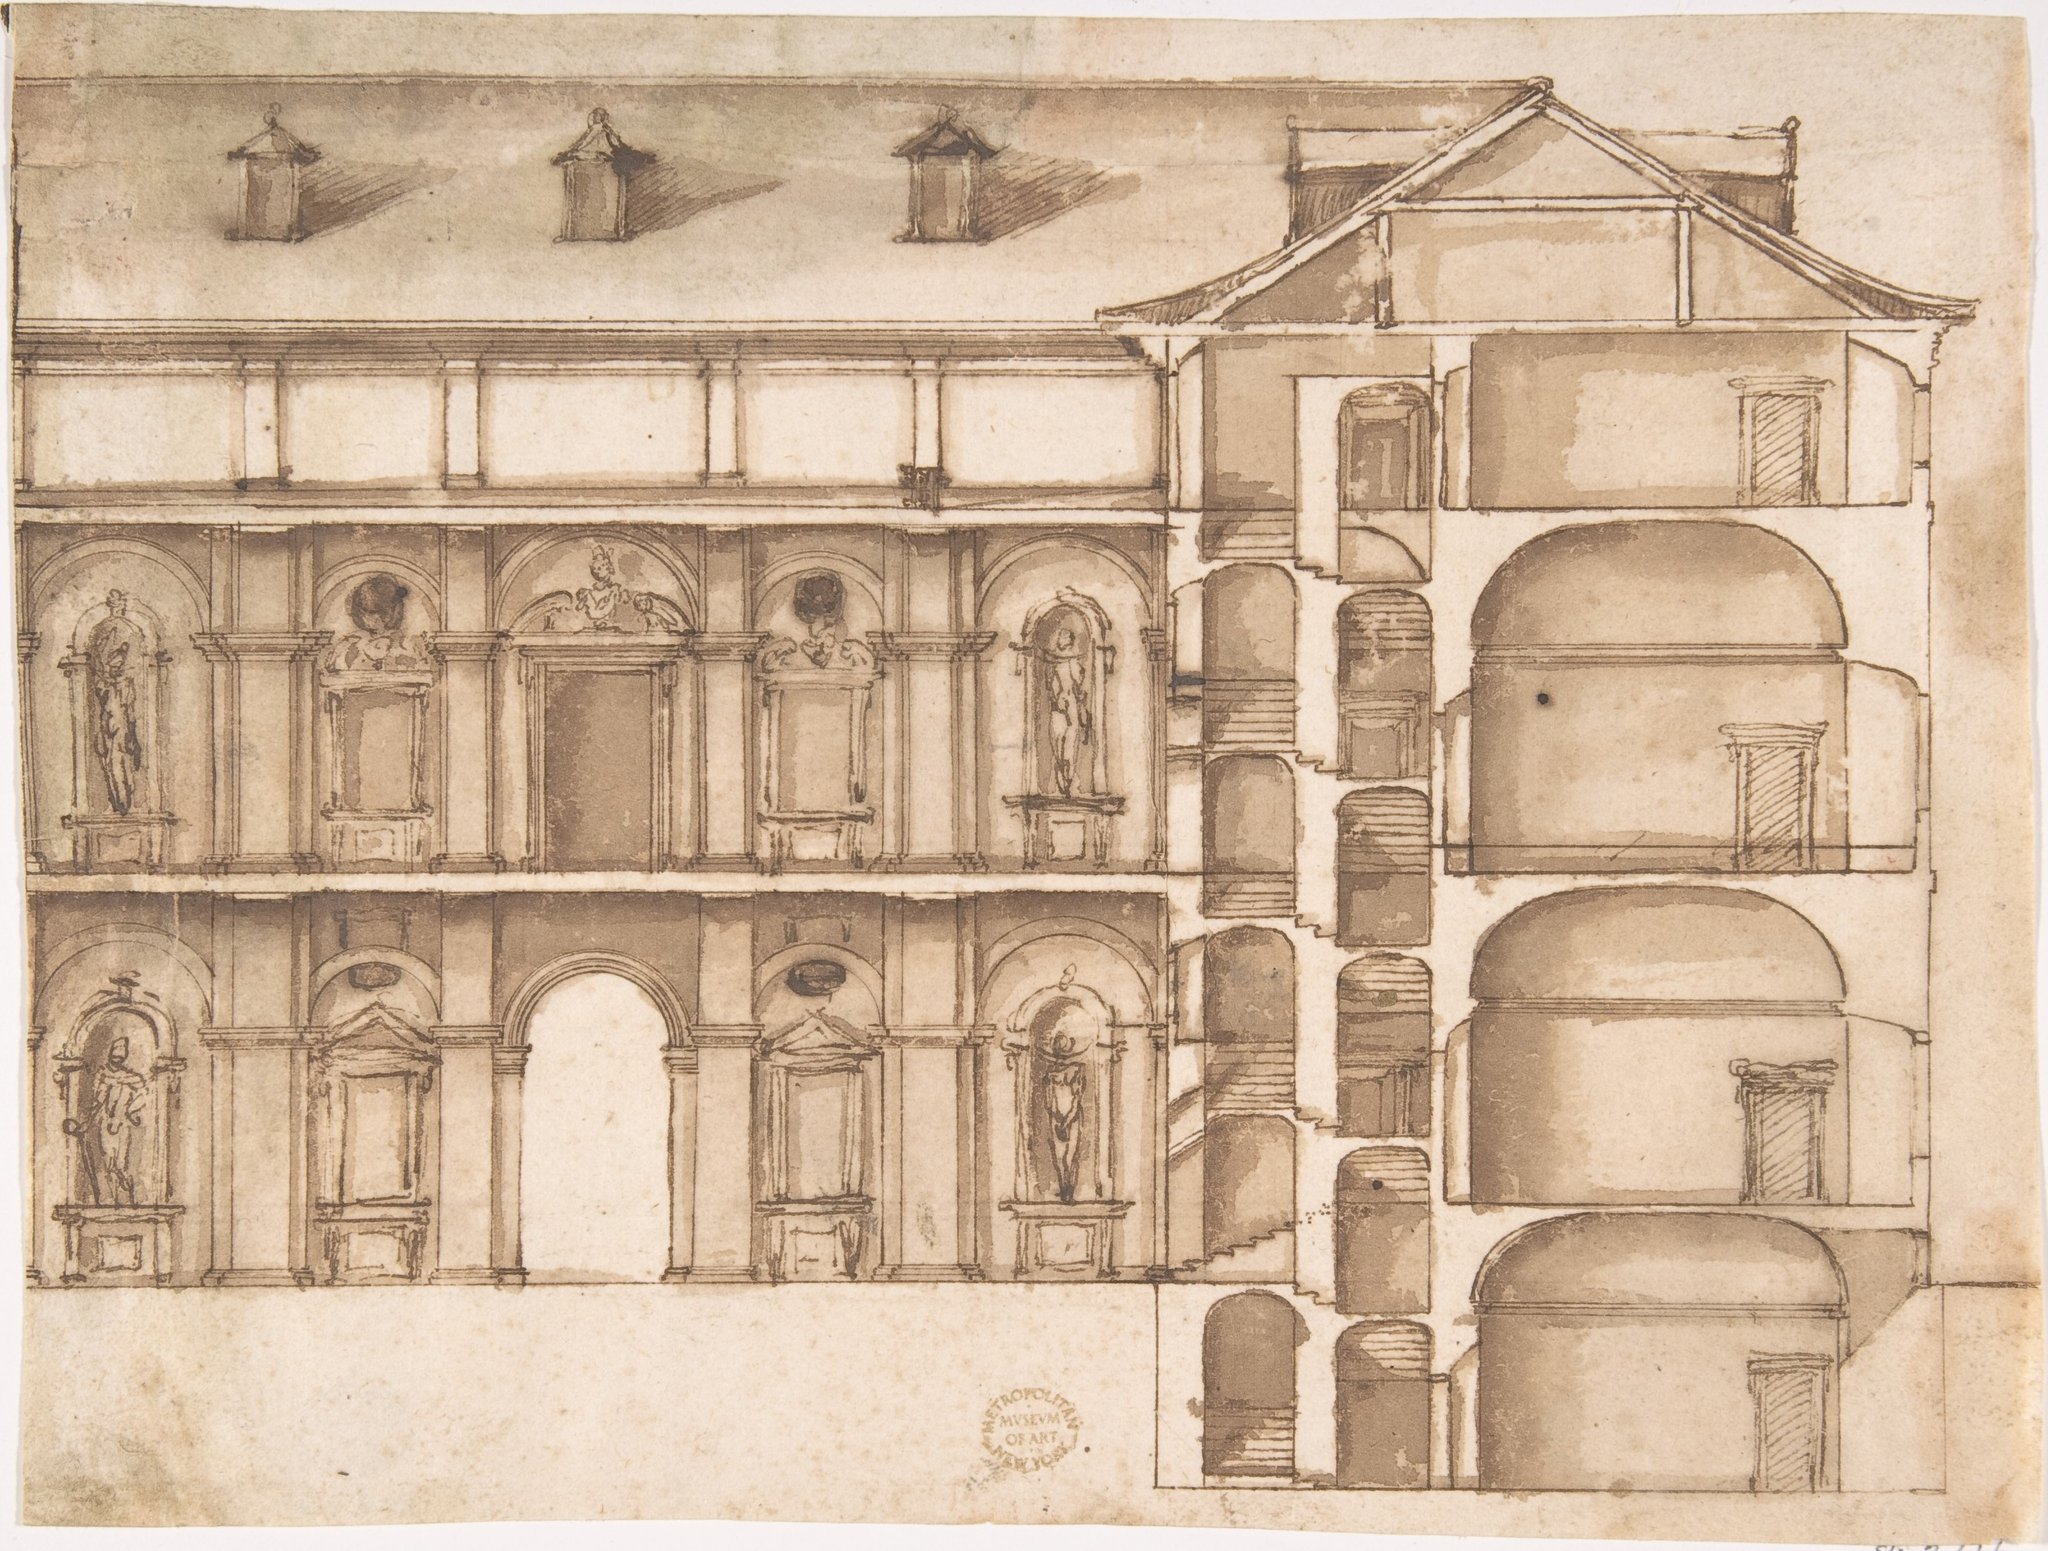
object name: drawing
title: Elevation and Section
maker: anonymous, italian, 16th century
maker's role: artist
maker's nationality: italian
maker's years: 1550-1600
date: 1501-1600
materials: ink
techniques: pen, wash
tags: architecture,buildings